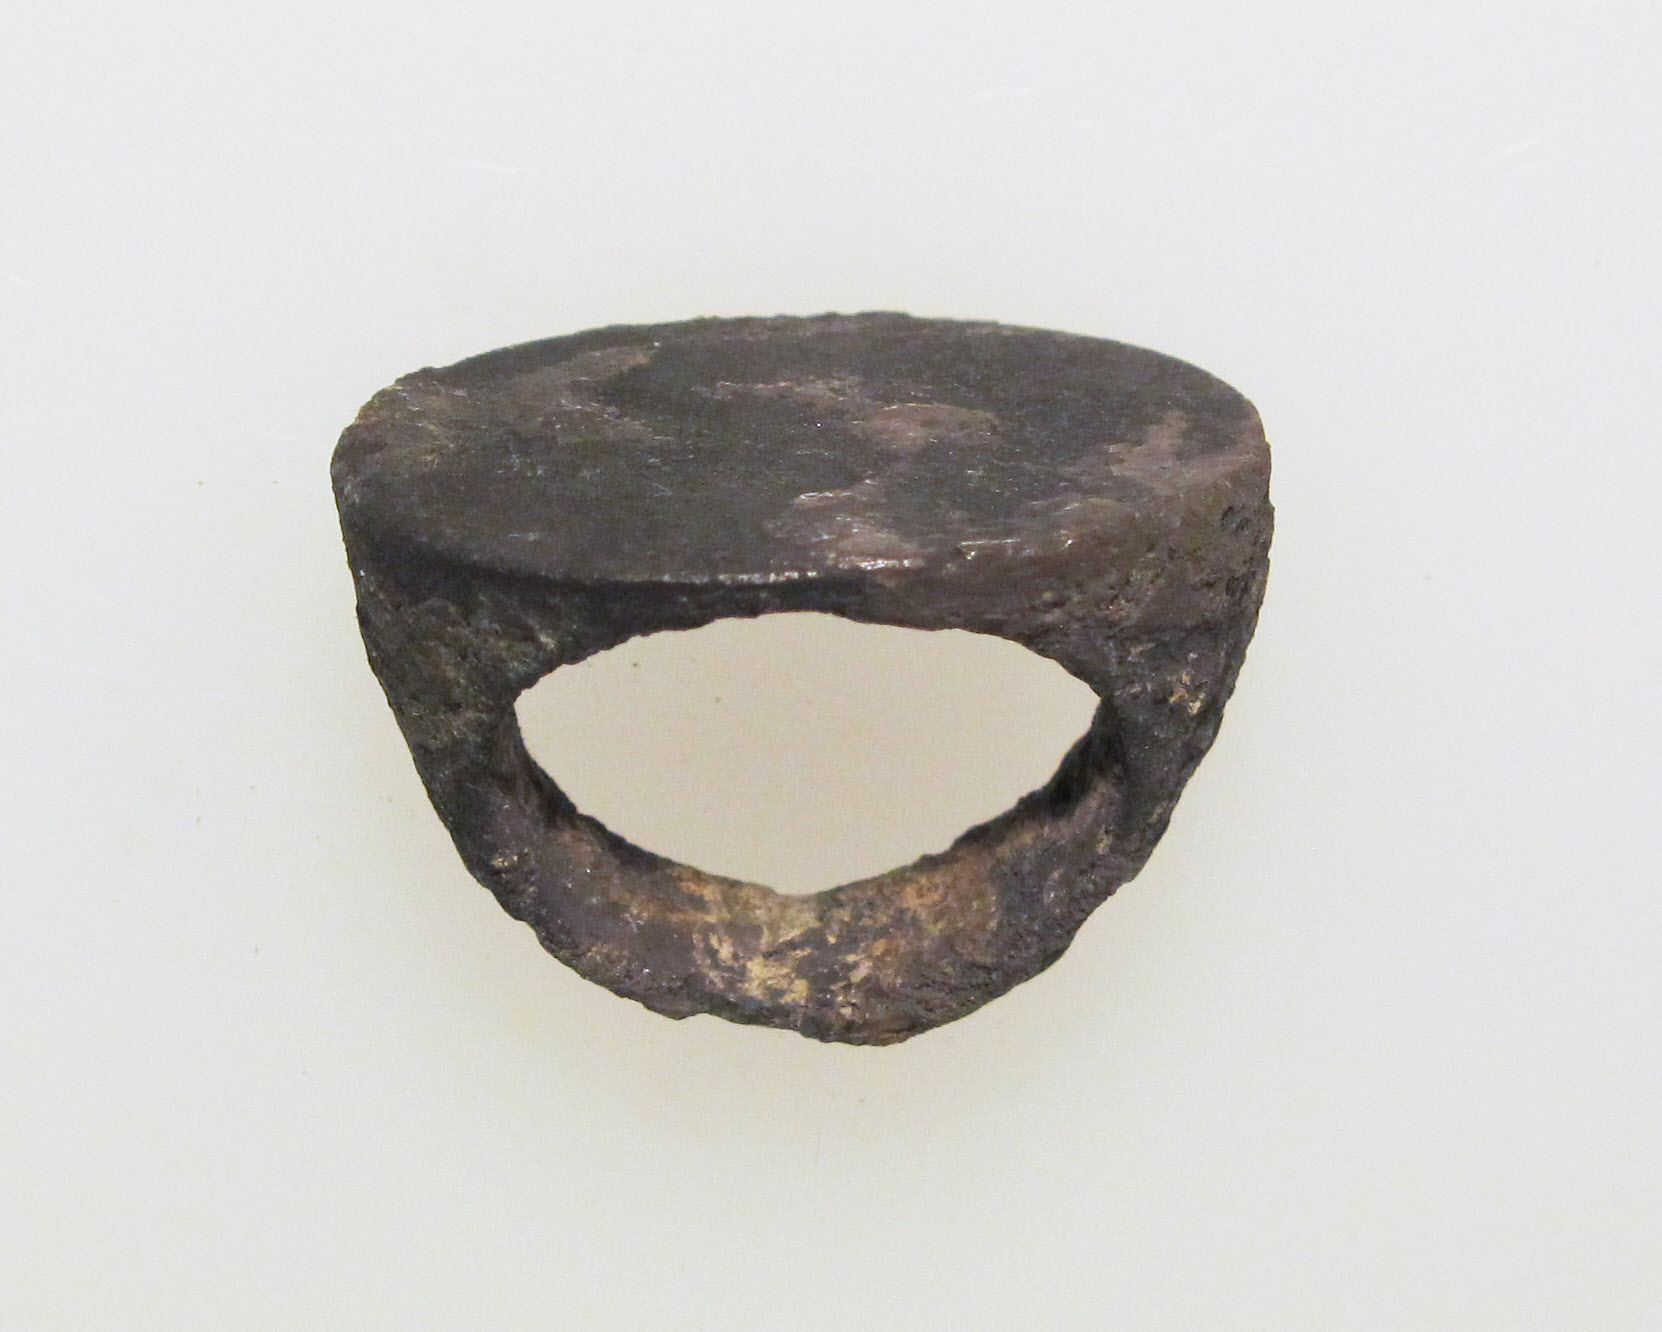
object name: ring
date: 7000 BCE-330 CE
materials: silver